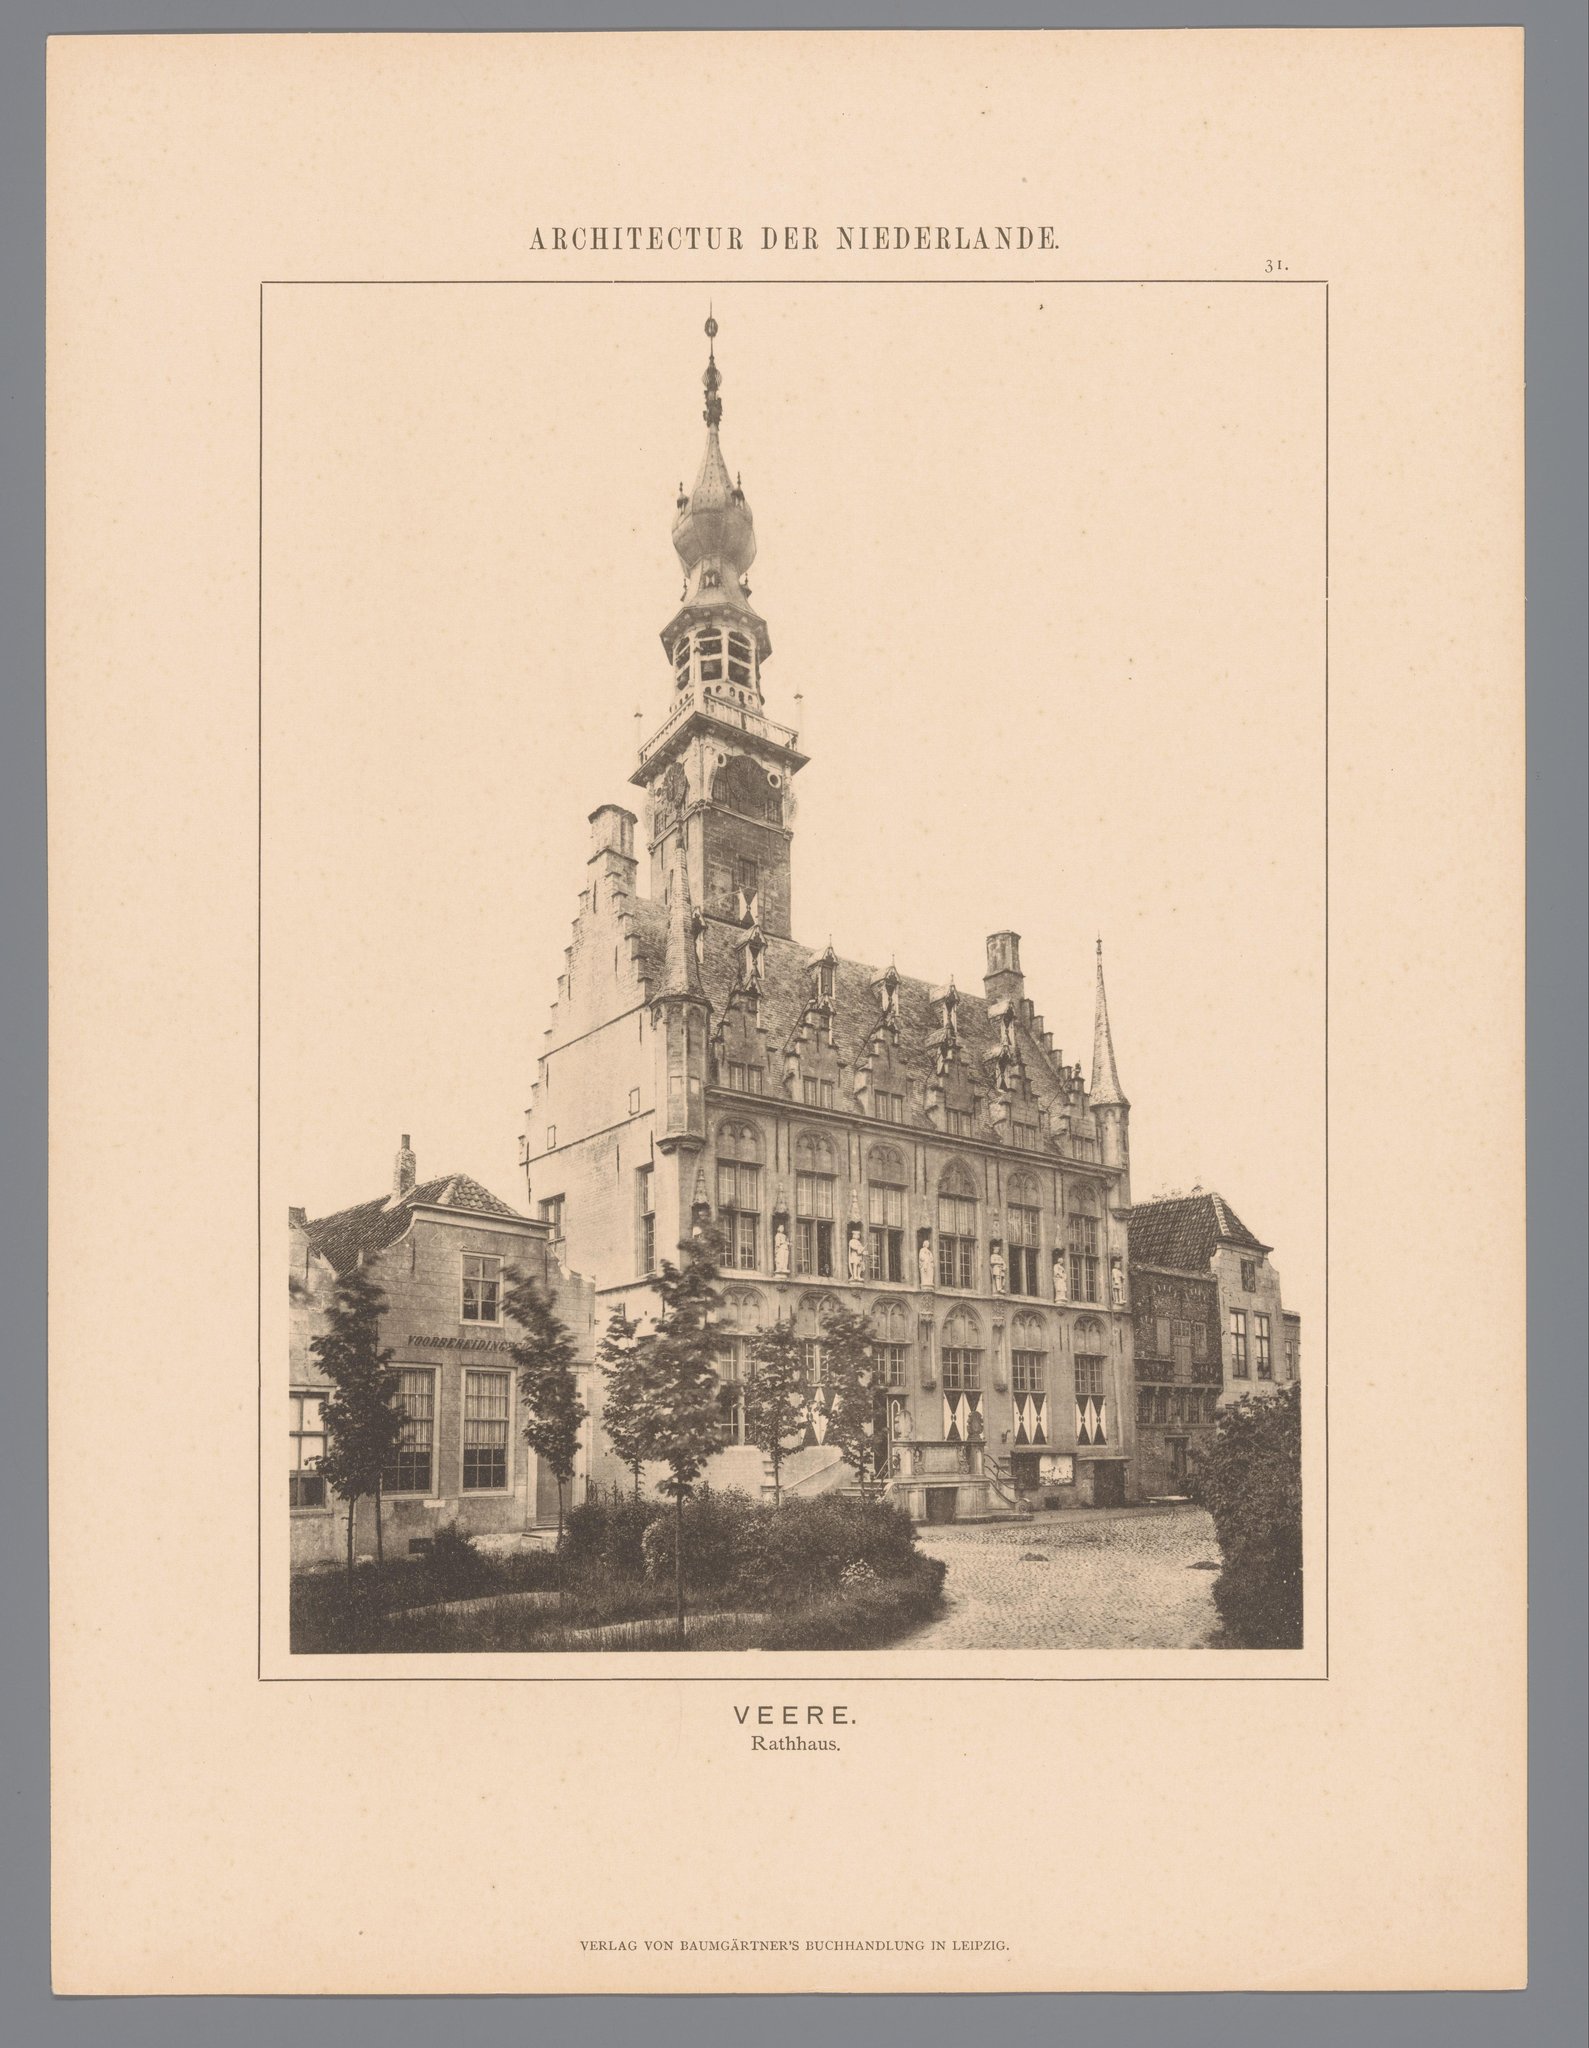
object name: photomechanical print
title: Veere, Rathhaus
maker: Anonymous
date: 1894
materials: paper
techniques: photograph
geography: leipzig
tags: townhall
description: Afdruk uit: Krook, L. Architectur der Niederlande. Leipzig: Baumgärtner's Buchhandlung, 1894.